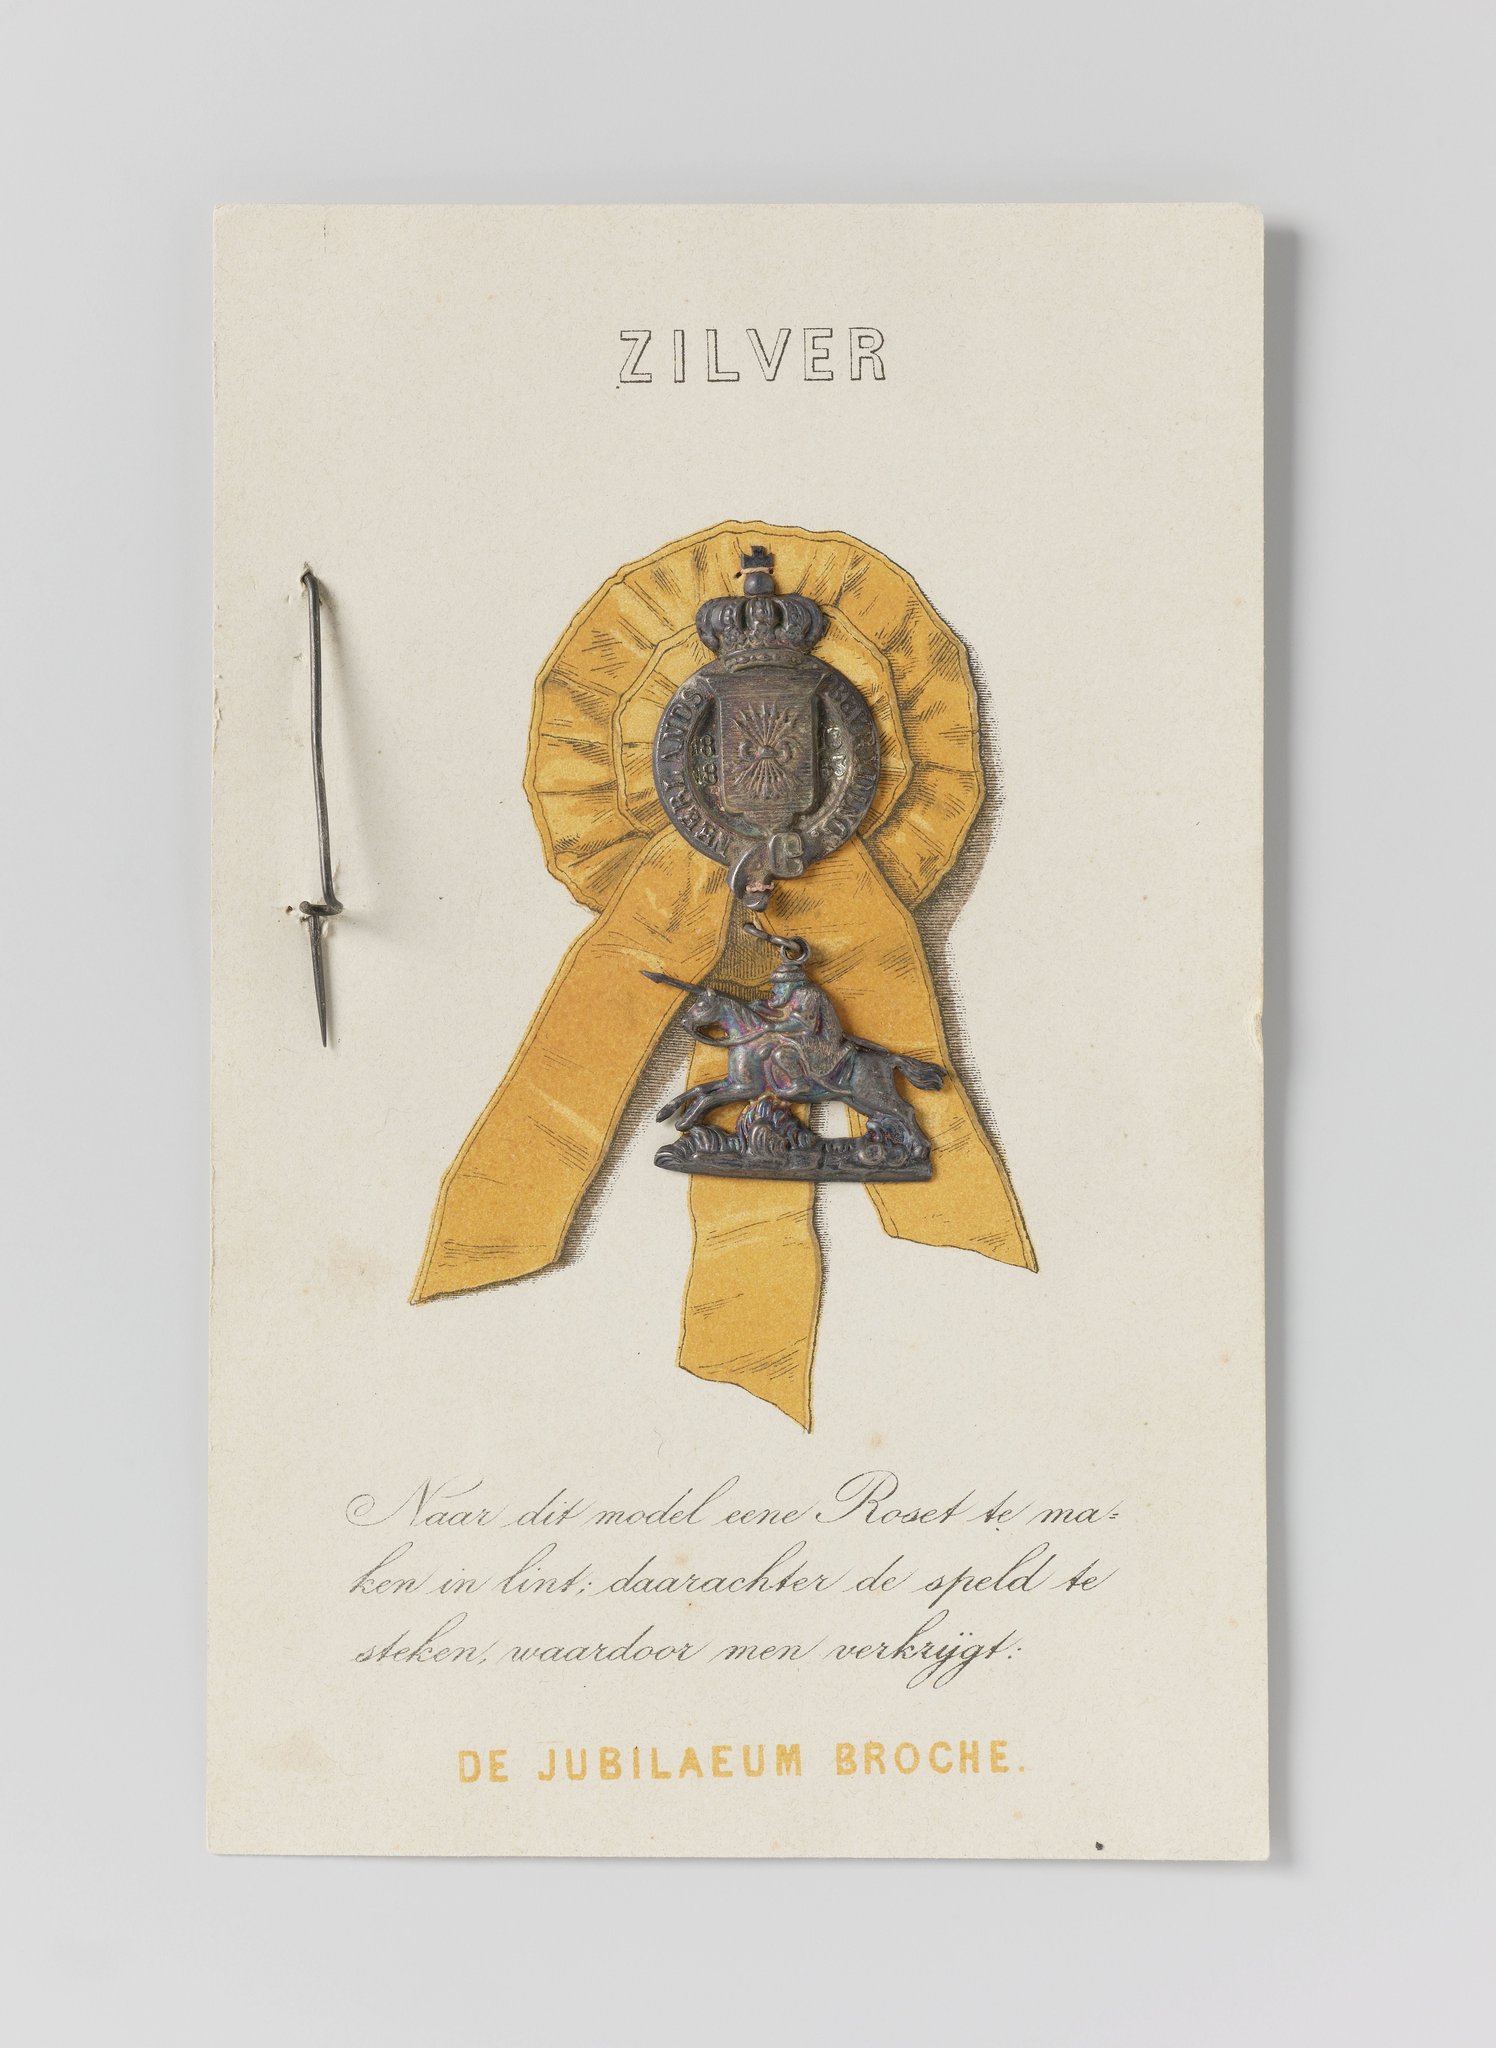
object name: insignia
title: De Jubilaeum Broche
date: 1863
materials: cardboard, paper, silver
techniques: printing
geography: voorschoten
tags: netherlands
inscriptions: date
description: Op stuk karton met tekst en oranje gedrukte rozet een rond zilveren draagteken waarop wapen met pijlenbundel en kroon; er omheen een riem met gesp en tekst. Links een metalen steekspeld in het karton gestoken. Onder het ronde draagteken een speld waaraan een hanger waarop een kozak te paard. Bijbehorende enveloppe met tekst. Opschrift op draagteken: NEERLANDS BEVRIJDING. / 1813 / 1863. ZILVER / Naar dit model.... men verkrijgt: / DE JUBILAEUM BROCHE. Voorzijde enveloppe: 1813 / 1863. TER BEZIGTIGING .... etc.